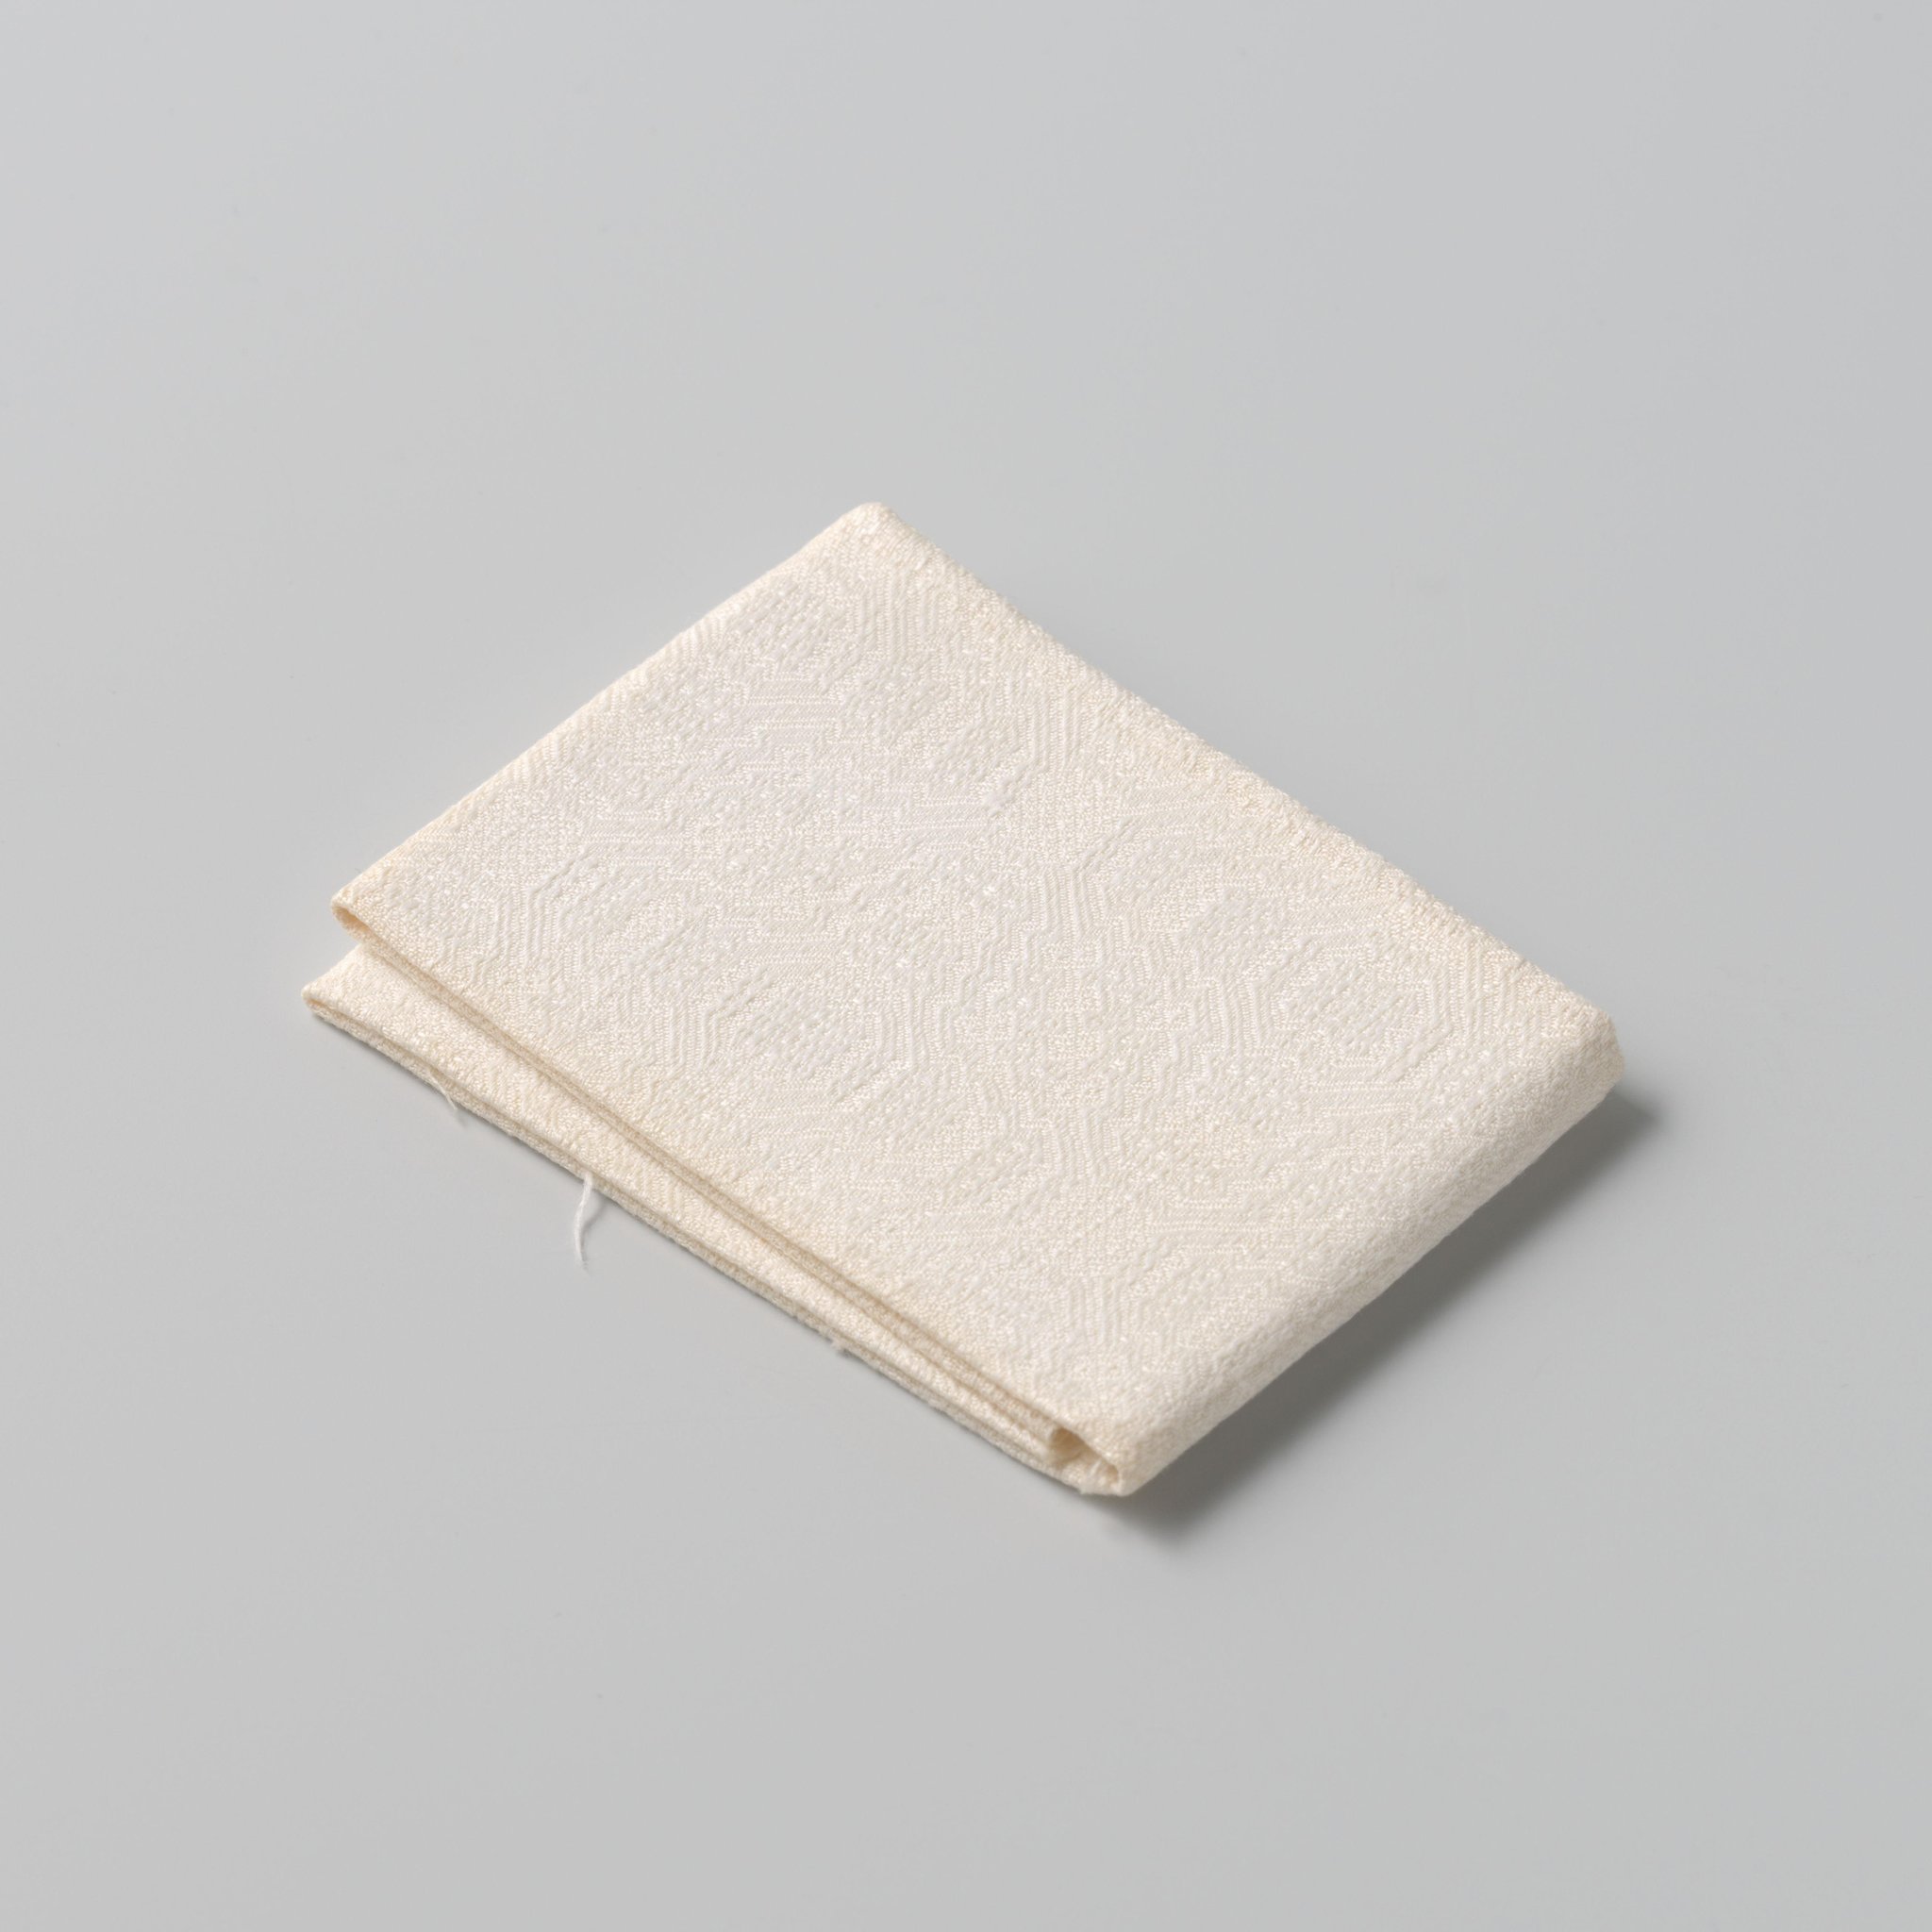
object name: miniature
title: Tafellaken, damastweefsel met pellenpatroon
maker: Anonymous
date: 1600-1699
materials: linen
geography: netherlands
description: Tafellaken, damastweefsel met pellenpatroon, geknipt uit een groter stuk linnen, niet omgezoomd.